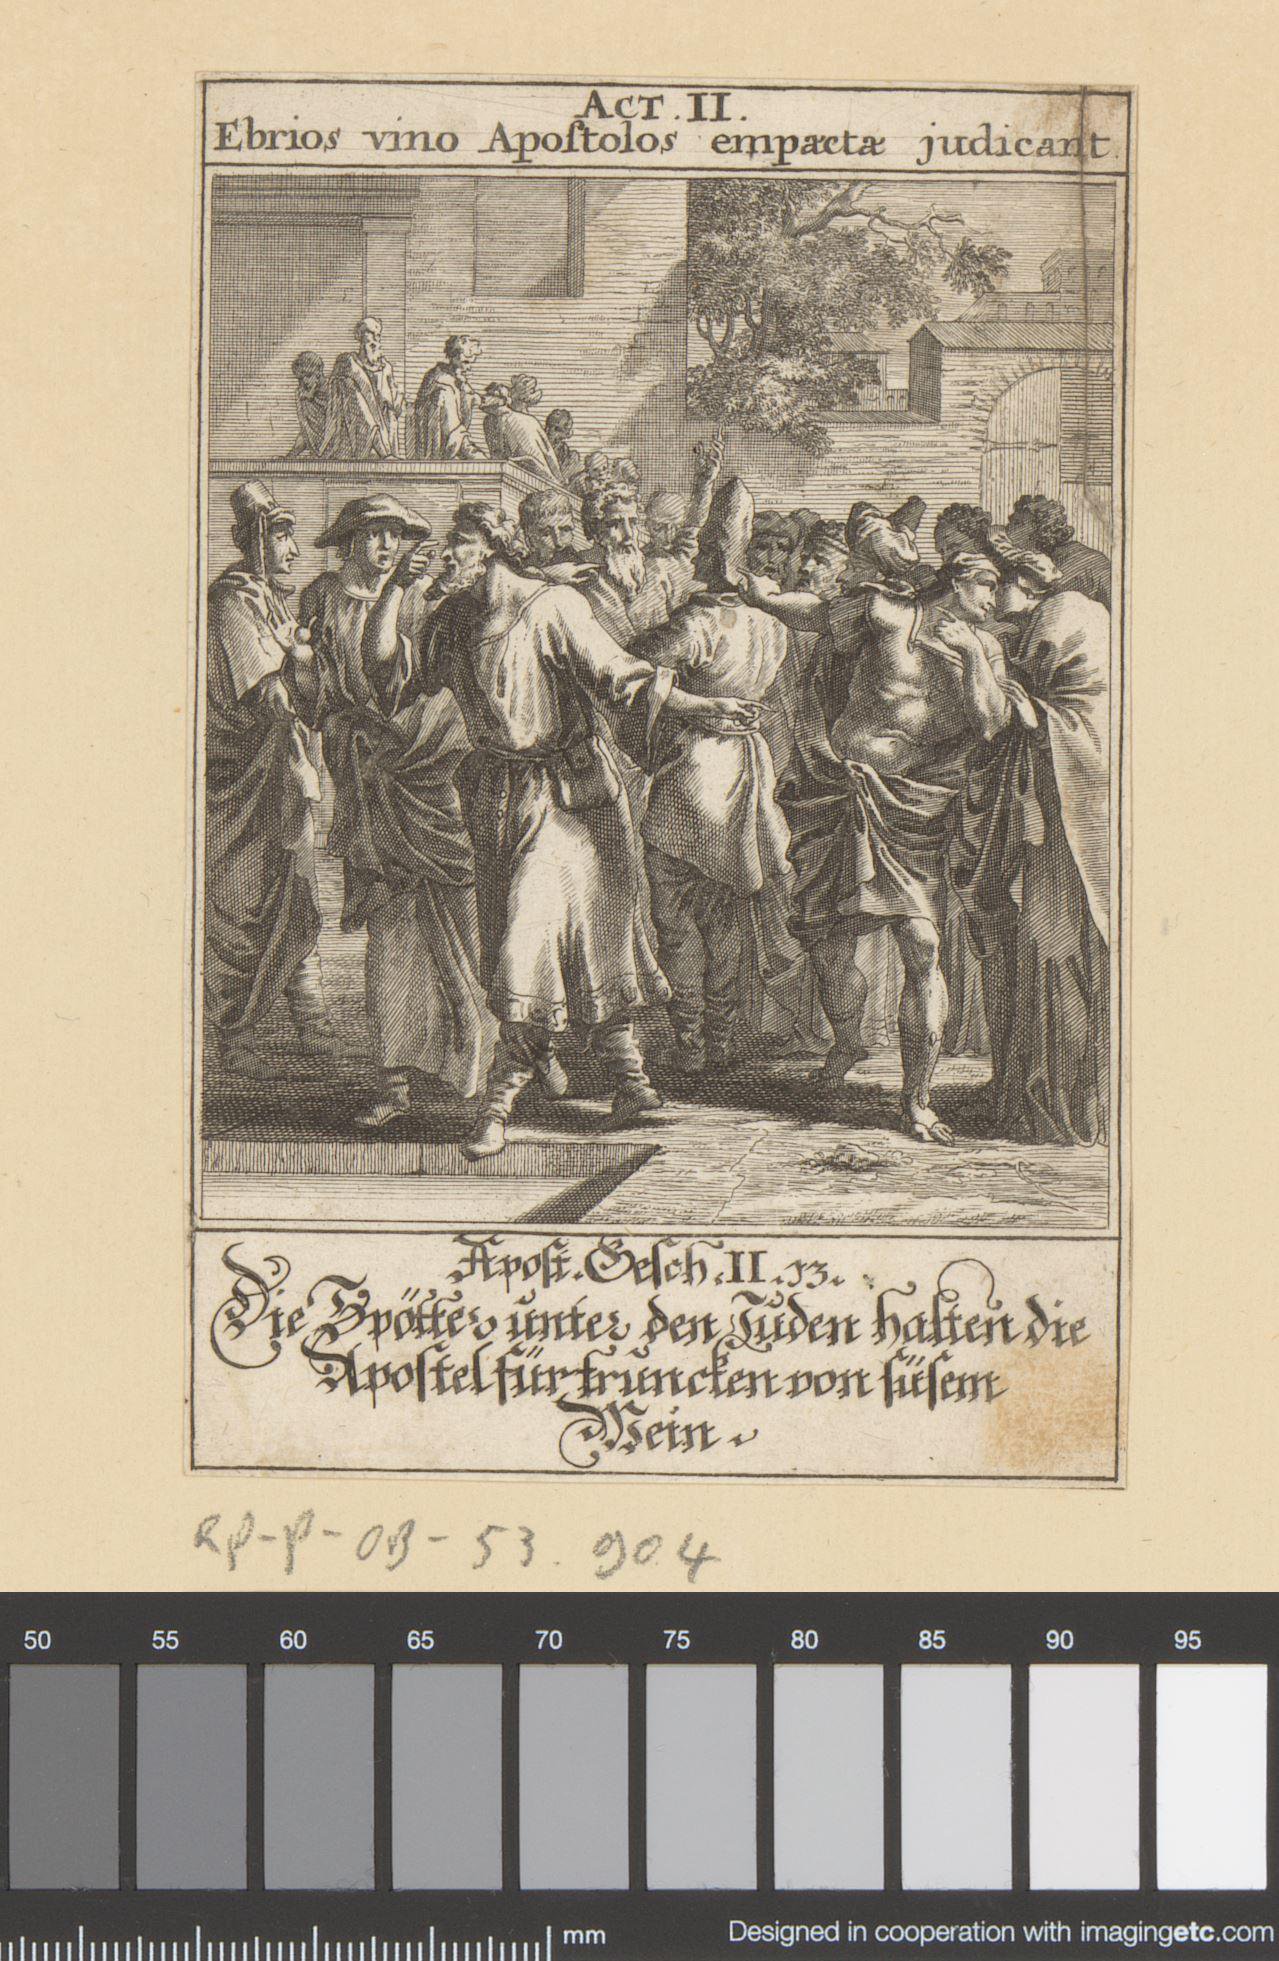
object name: print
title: Apostelen beschuldigd van teveel wijn gedronken te hebben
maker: Anonymous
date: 1697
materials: paper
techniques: etching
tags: pentecost: the holy ghost descends upon (mary and) the apostles, sometimes paul and/or representatives of the nations present (acts 2:1-4)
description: Prent ook gebruikt in: Biblia ectypa : Bildnussen auss Heiliger Schrifft. Regensburg: Chr. Wiegel, 1697.